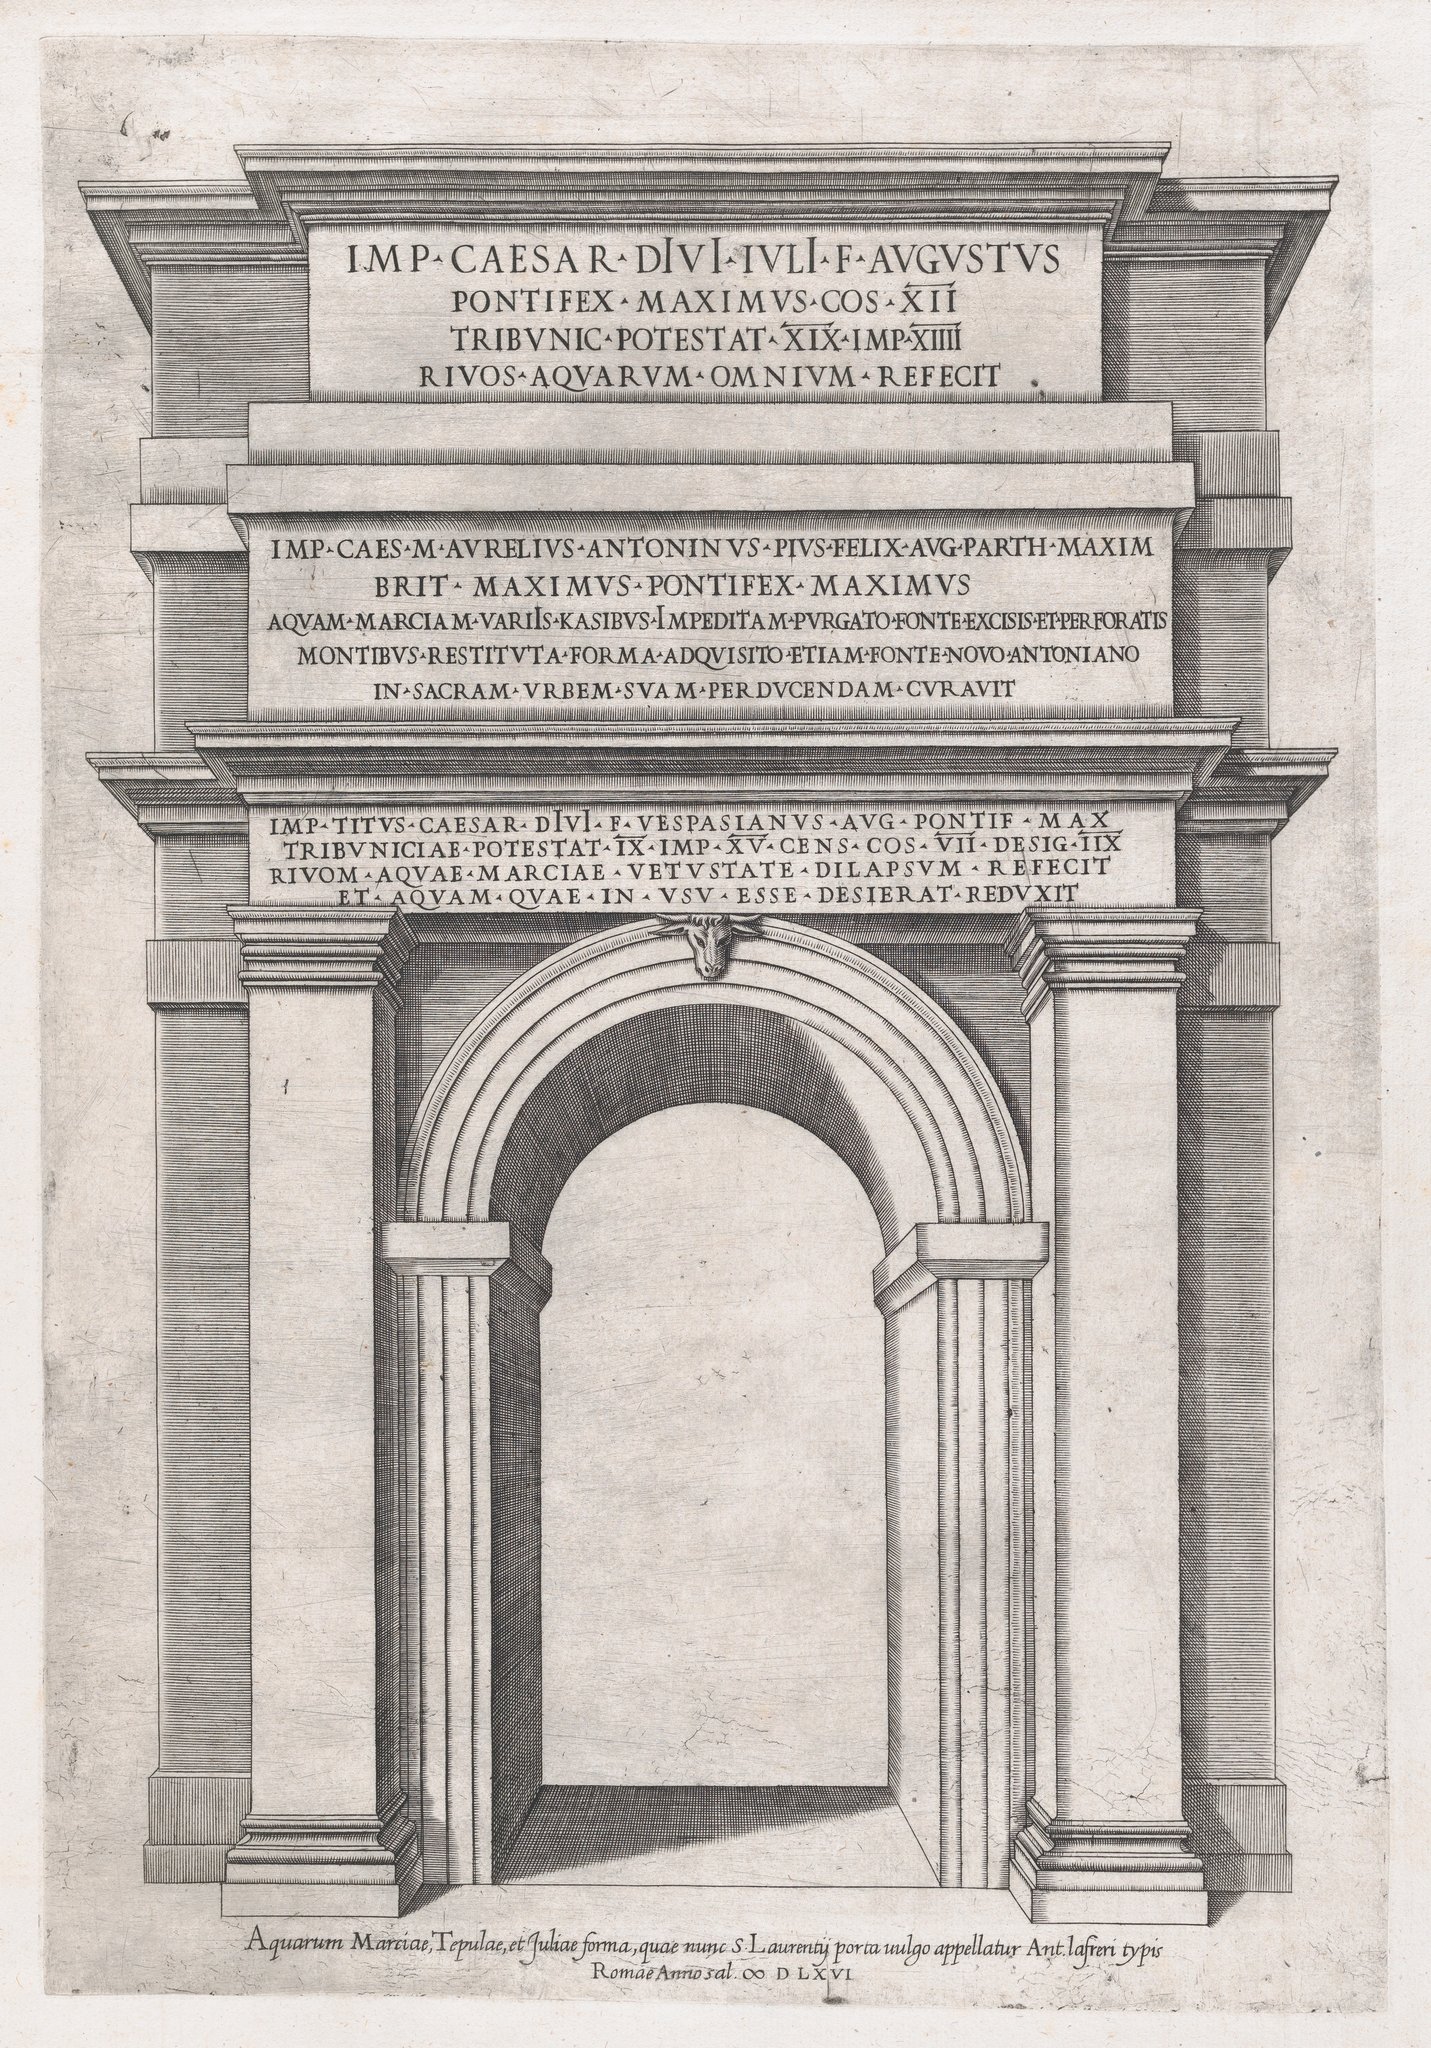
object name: print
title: Front view of St. Lawrence Gateway, Rome, from "Speculum Romanae Magnificentiae"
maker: Anonymous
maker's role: artist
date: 1566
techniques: engraving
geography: rome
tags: gates,rome